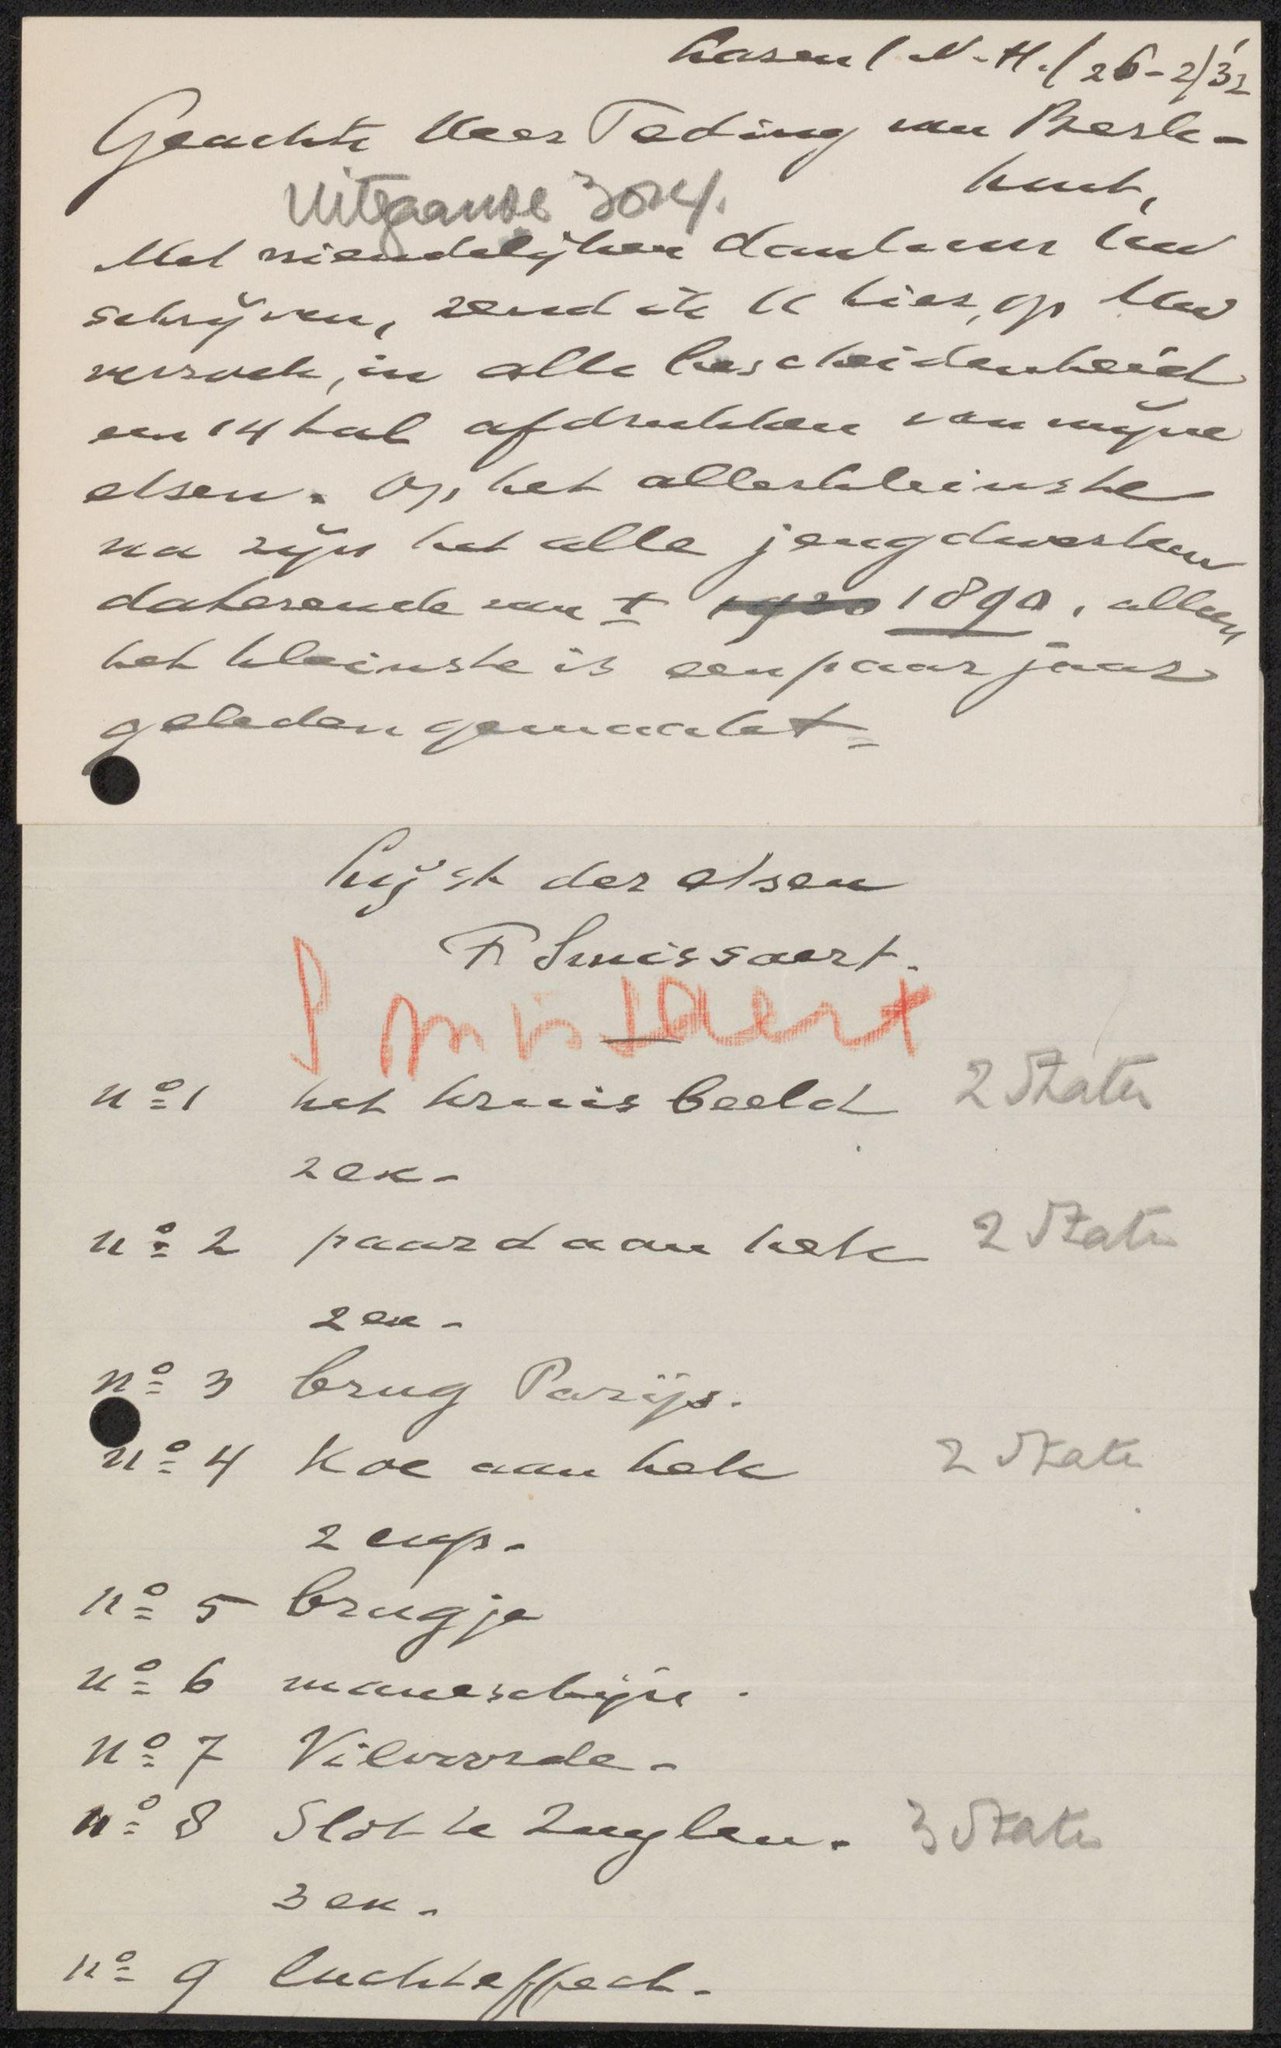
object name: letter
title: Brief aan jonkheer Hendrik Teding van Berkhout (1879-1969)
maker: frans smissaert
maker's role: draughtsman, print maker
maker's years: 1862-1944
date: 1932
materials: ink, paper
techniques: pen, writing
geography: laren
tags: haarlem, amsterdam, jonkheer hendrik teding van berkhout (1879-1969), the graphic arts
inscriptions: collector's mark: ‘RPK’